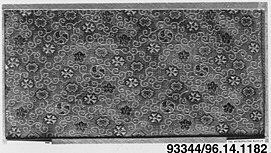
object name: piece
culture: japanese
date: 1701-1900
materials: silk